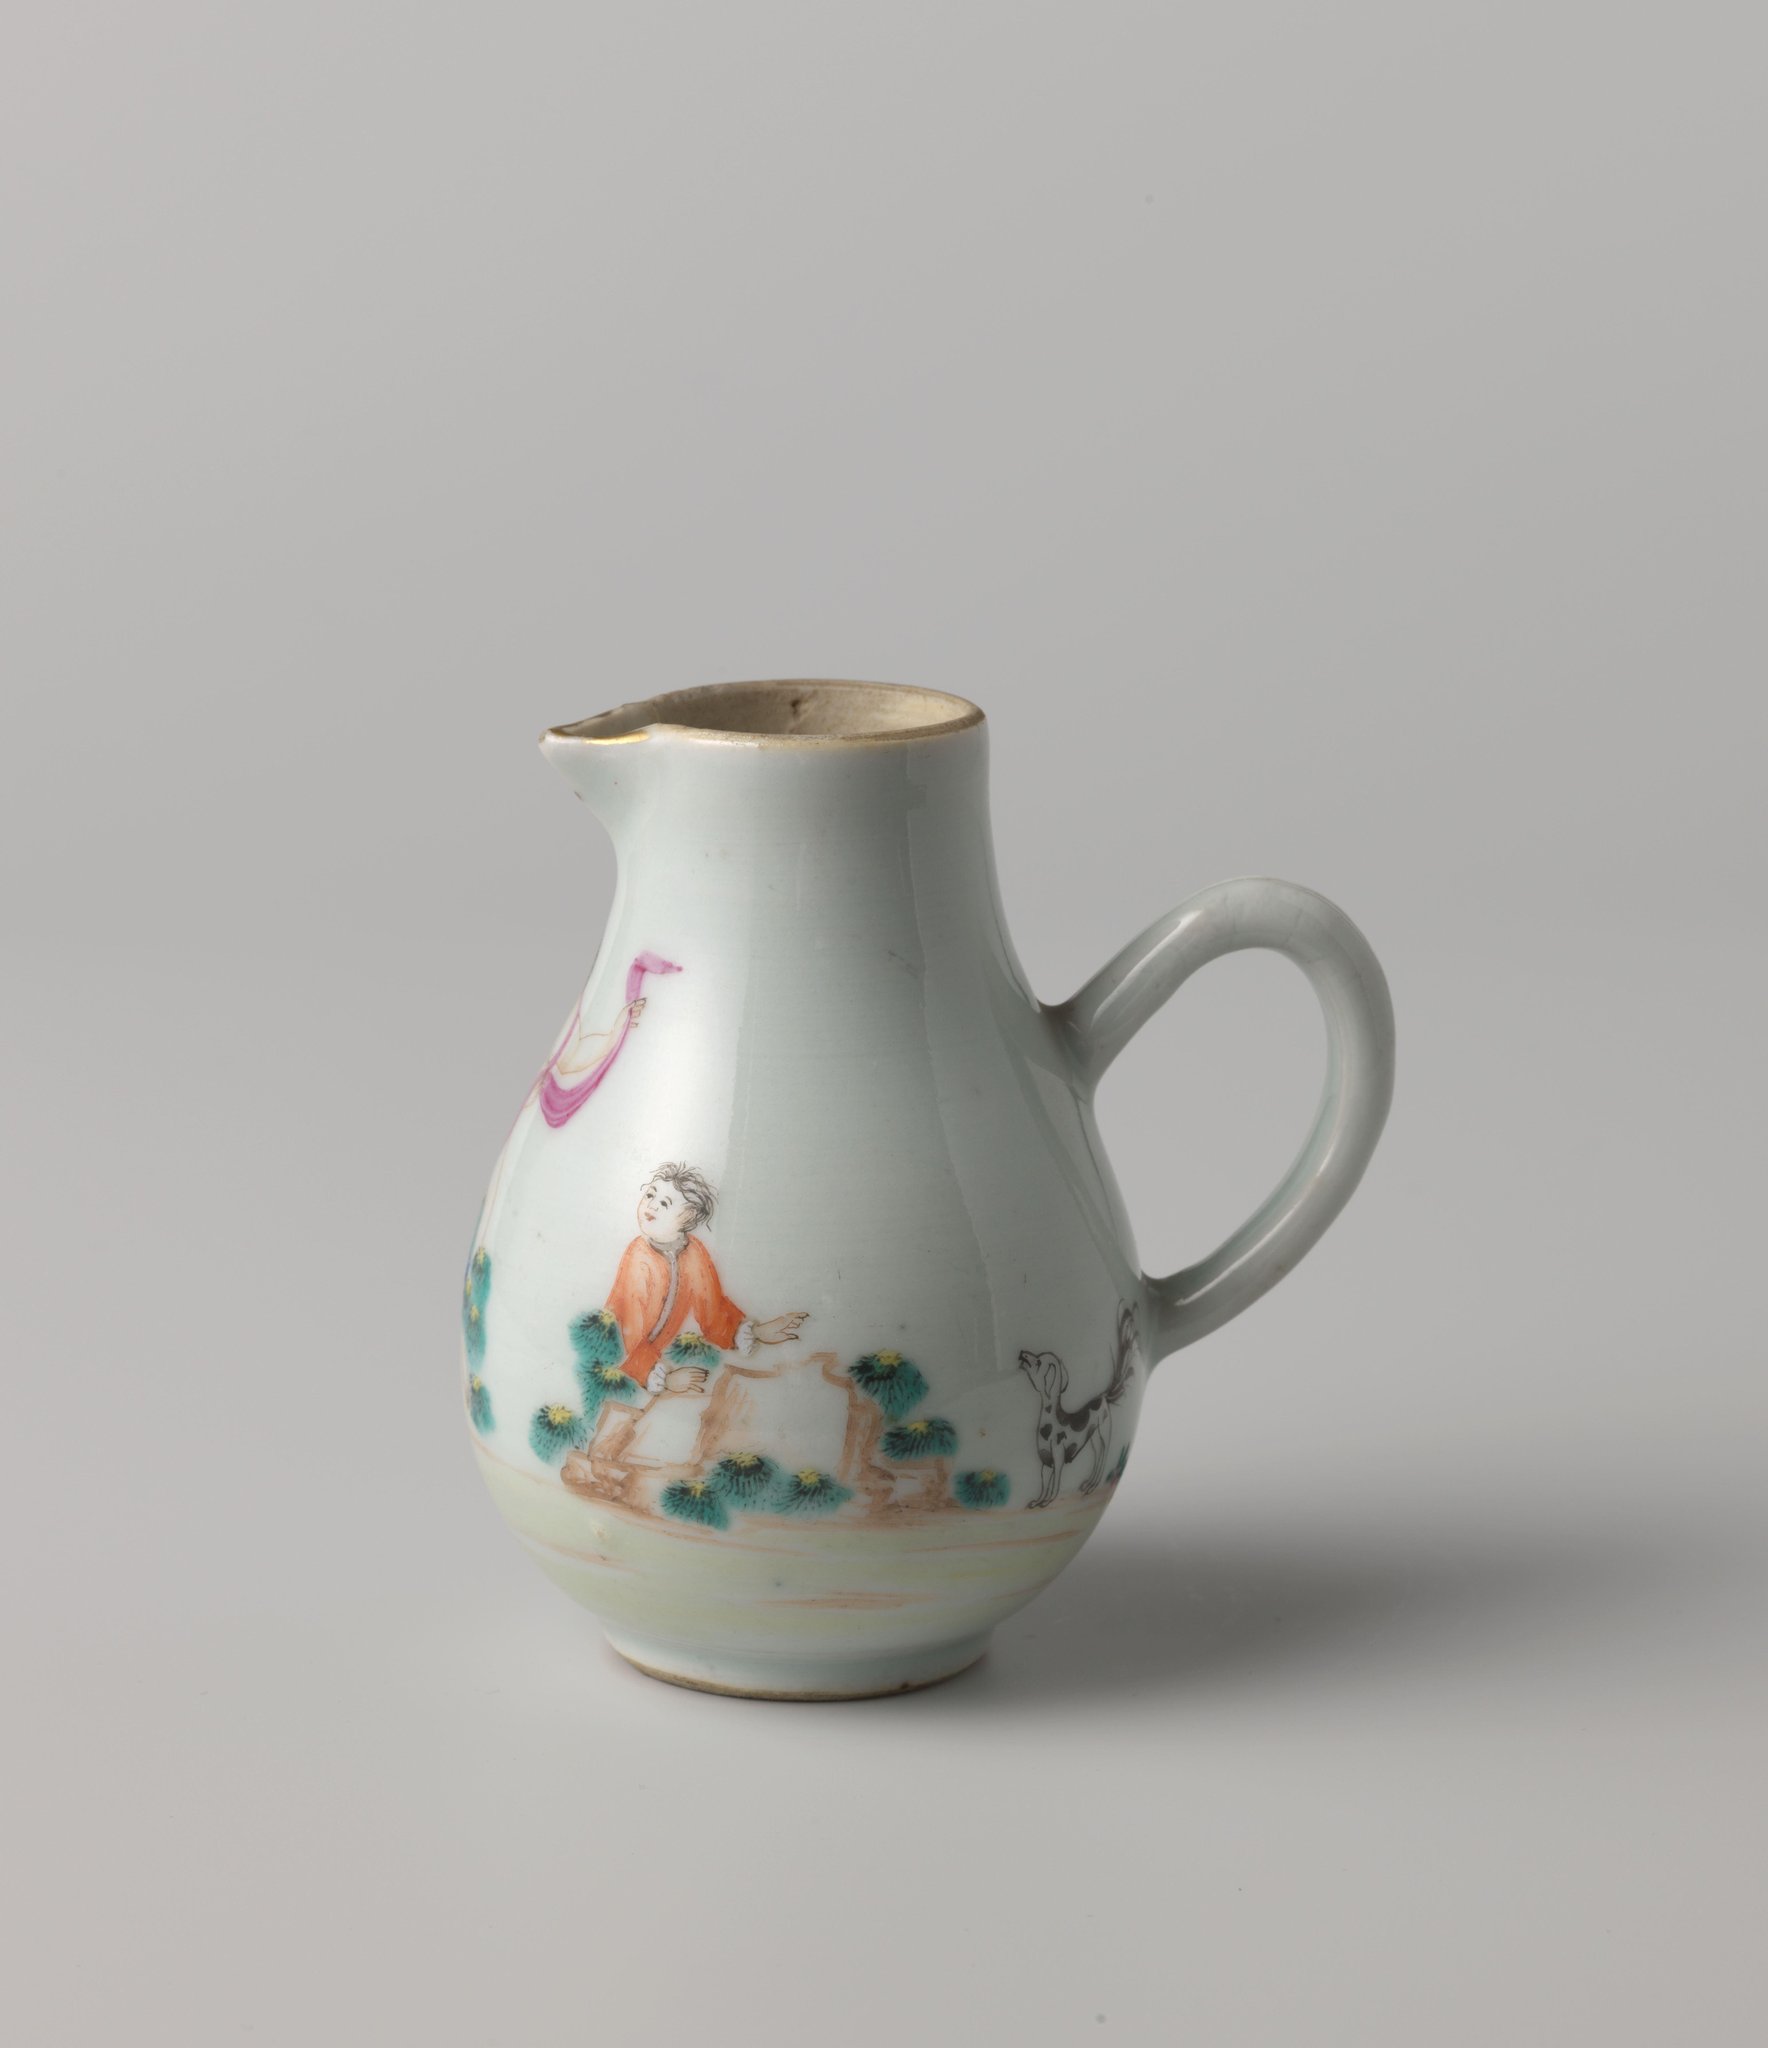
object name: milk jug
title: Pear-shaped milkjug with two women, a man and boy with a dog in a landscape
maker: Anonymous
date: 1750-1774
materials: glaze, gold, paint, porcelain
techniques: firing, gilding, turning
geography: china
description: Peervormige melkkan van porselein, met c-vormig oor en kleine, driehoekige tuit, beschilderd op het glazuur in blauw, rood, roze, groen, geel, zwart en goud. Op de buik een doorlopende voorstelling van drie klassiek ogende, Europese, halfnaakte mensen, twee vrouwen en een man, met een jongen en een hond in een landschap. Deksel ontbreekt. Europese vorm en voorstelling in emailkleuren.